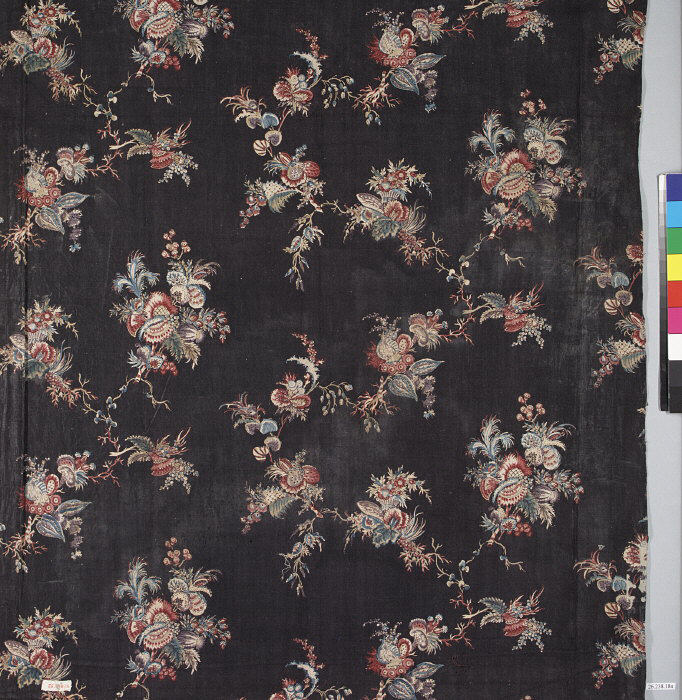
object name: piece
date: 1775-1780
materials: cotton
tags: flowers